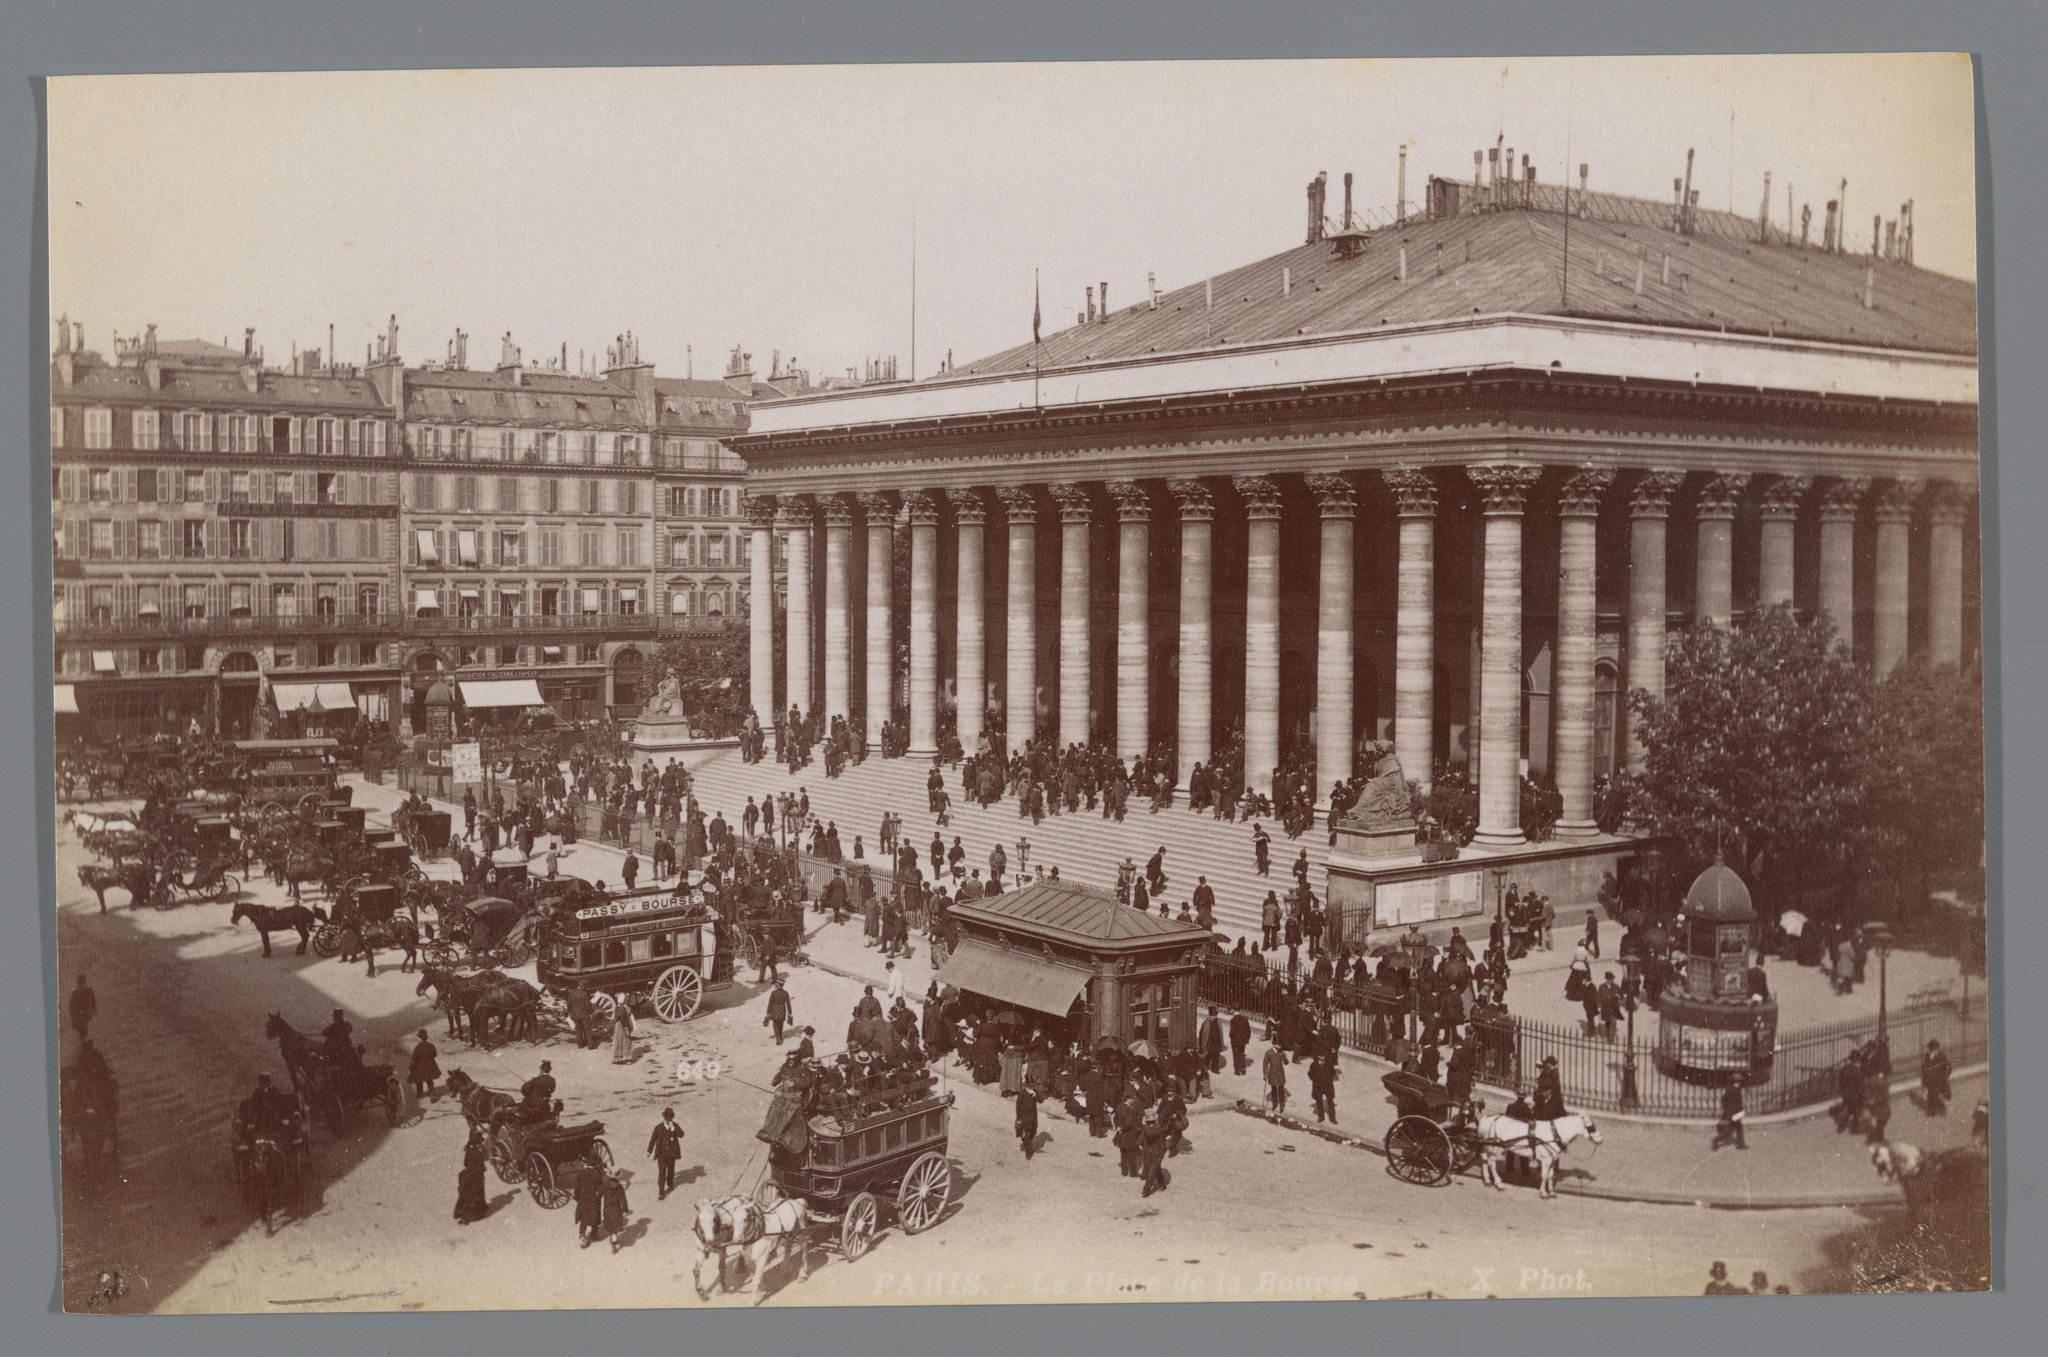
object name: photograph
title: Gezicht op de Beurs van Parijs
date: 1887-1900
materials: paper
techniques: albumen print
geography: paris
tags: square, place, circus, etc., stock exchange, stock-market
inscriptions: number: ‘889’, inscription: ‘Parijs. La Bourse’, number: ‘649’